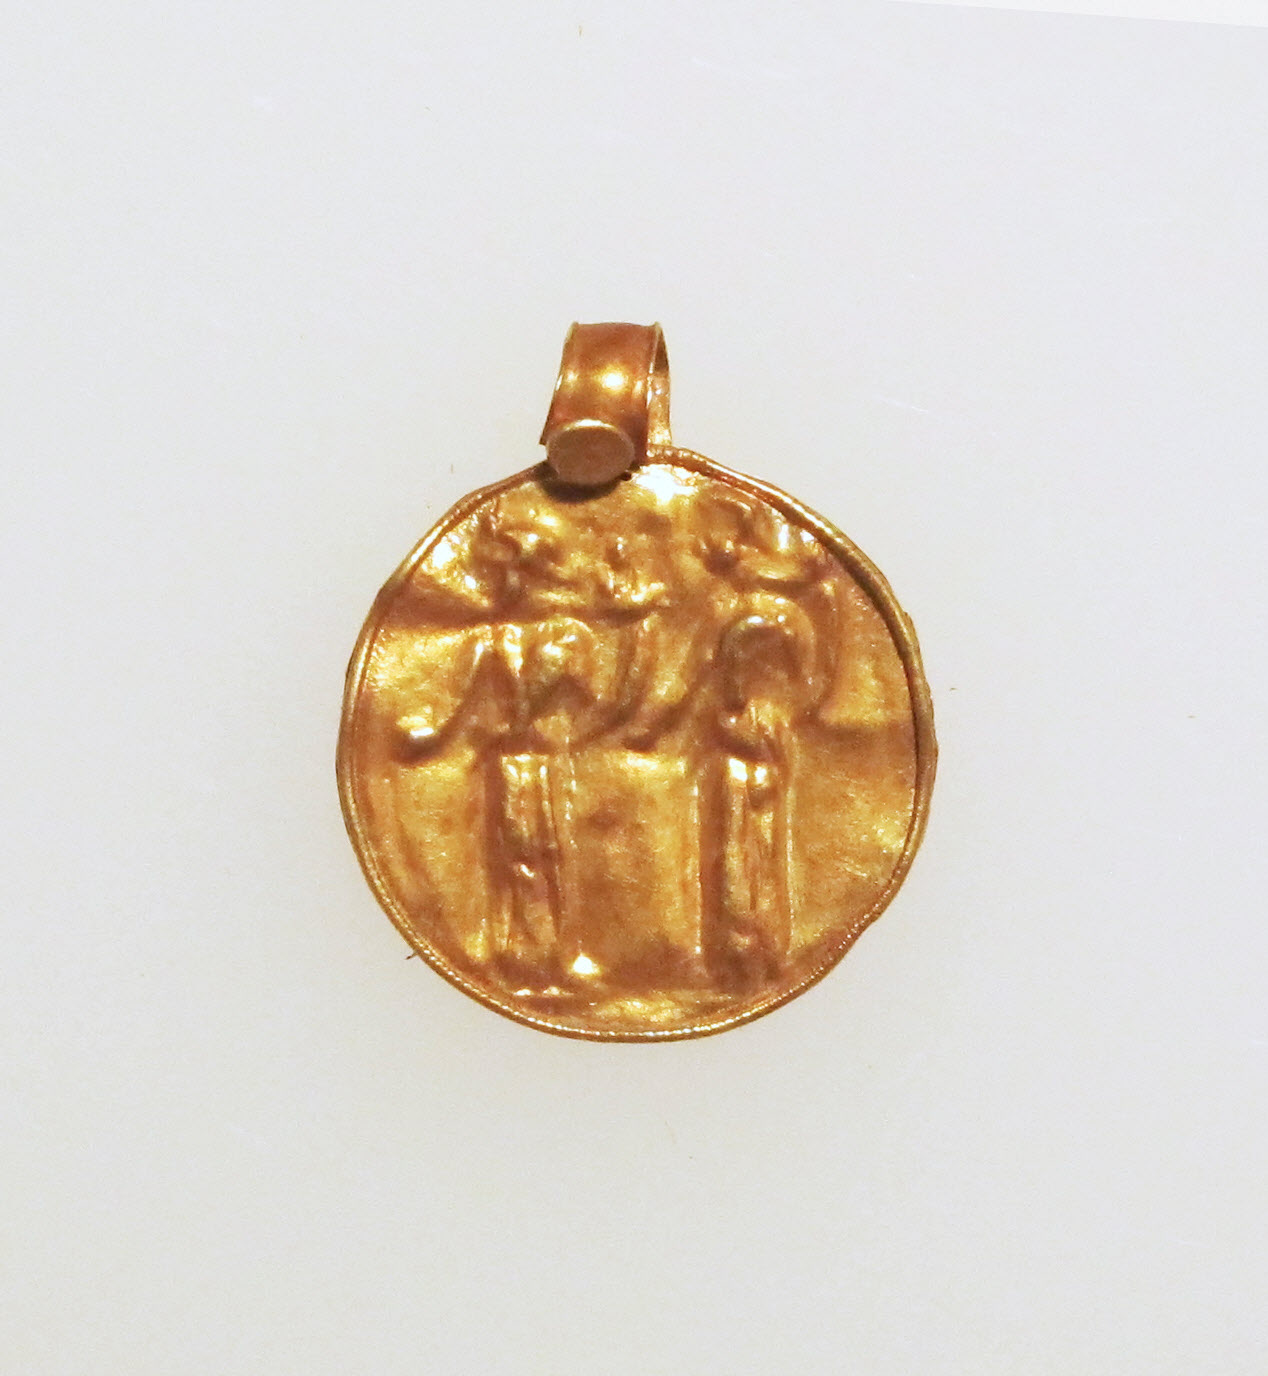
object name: roundel, disk with two goddess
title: Roundel, disk with two goddesses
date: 400-301 BCE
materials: gold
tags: goddess